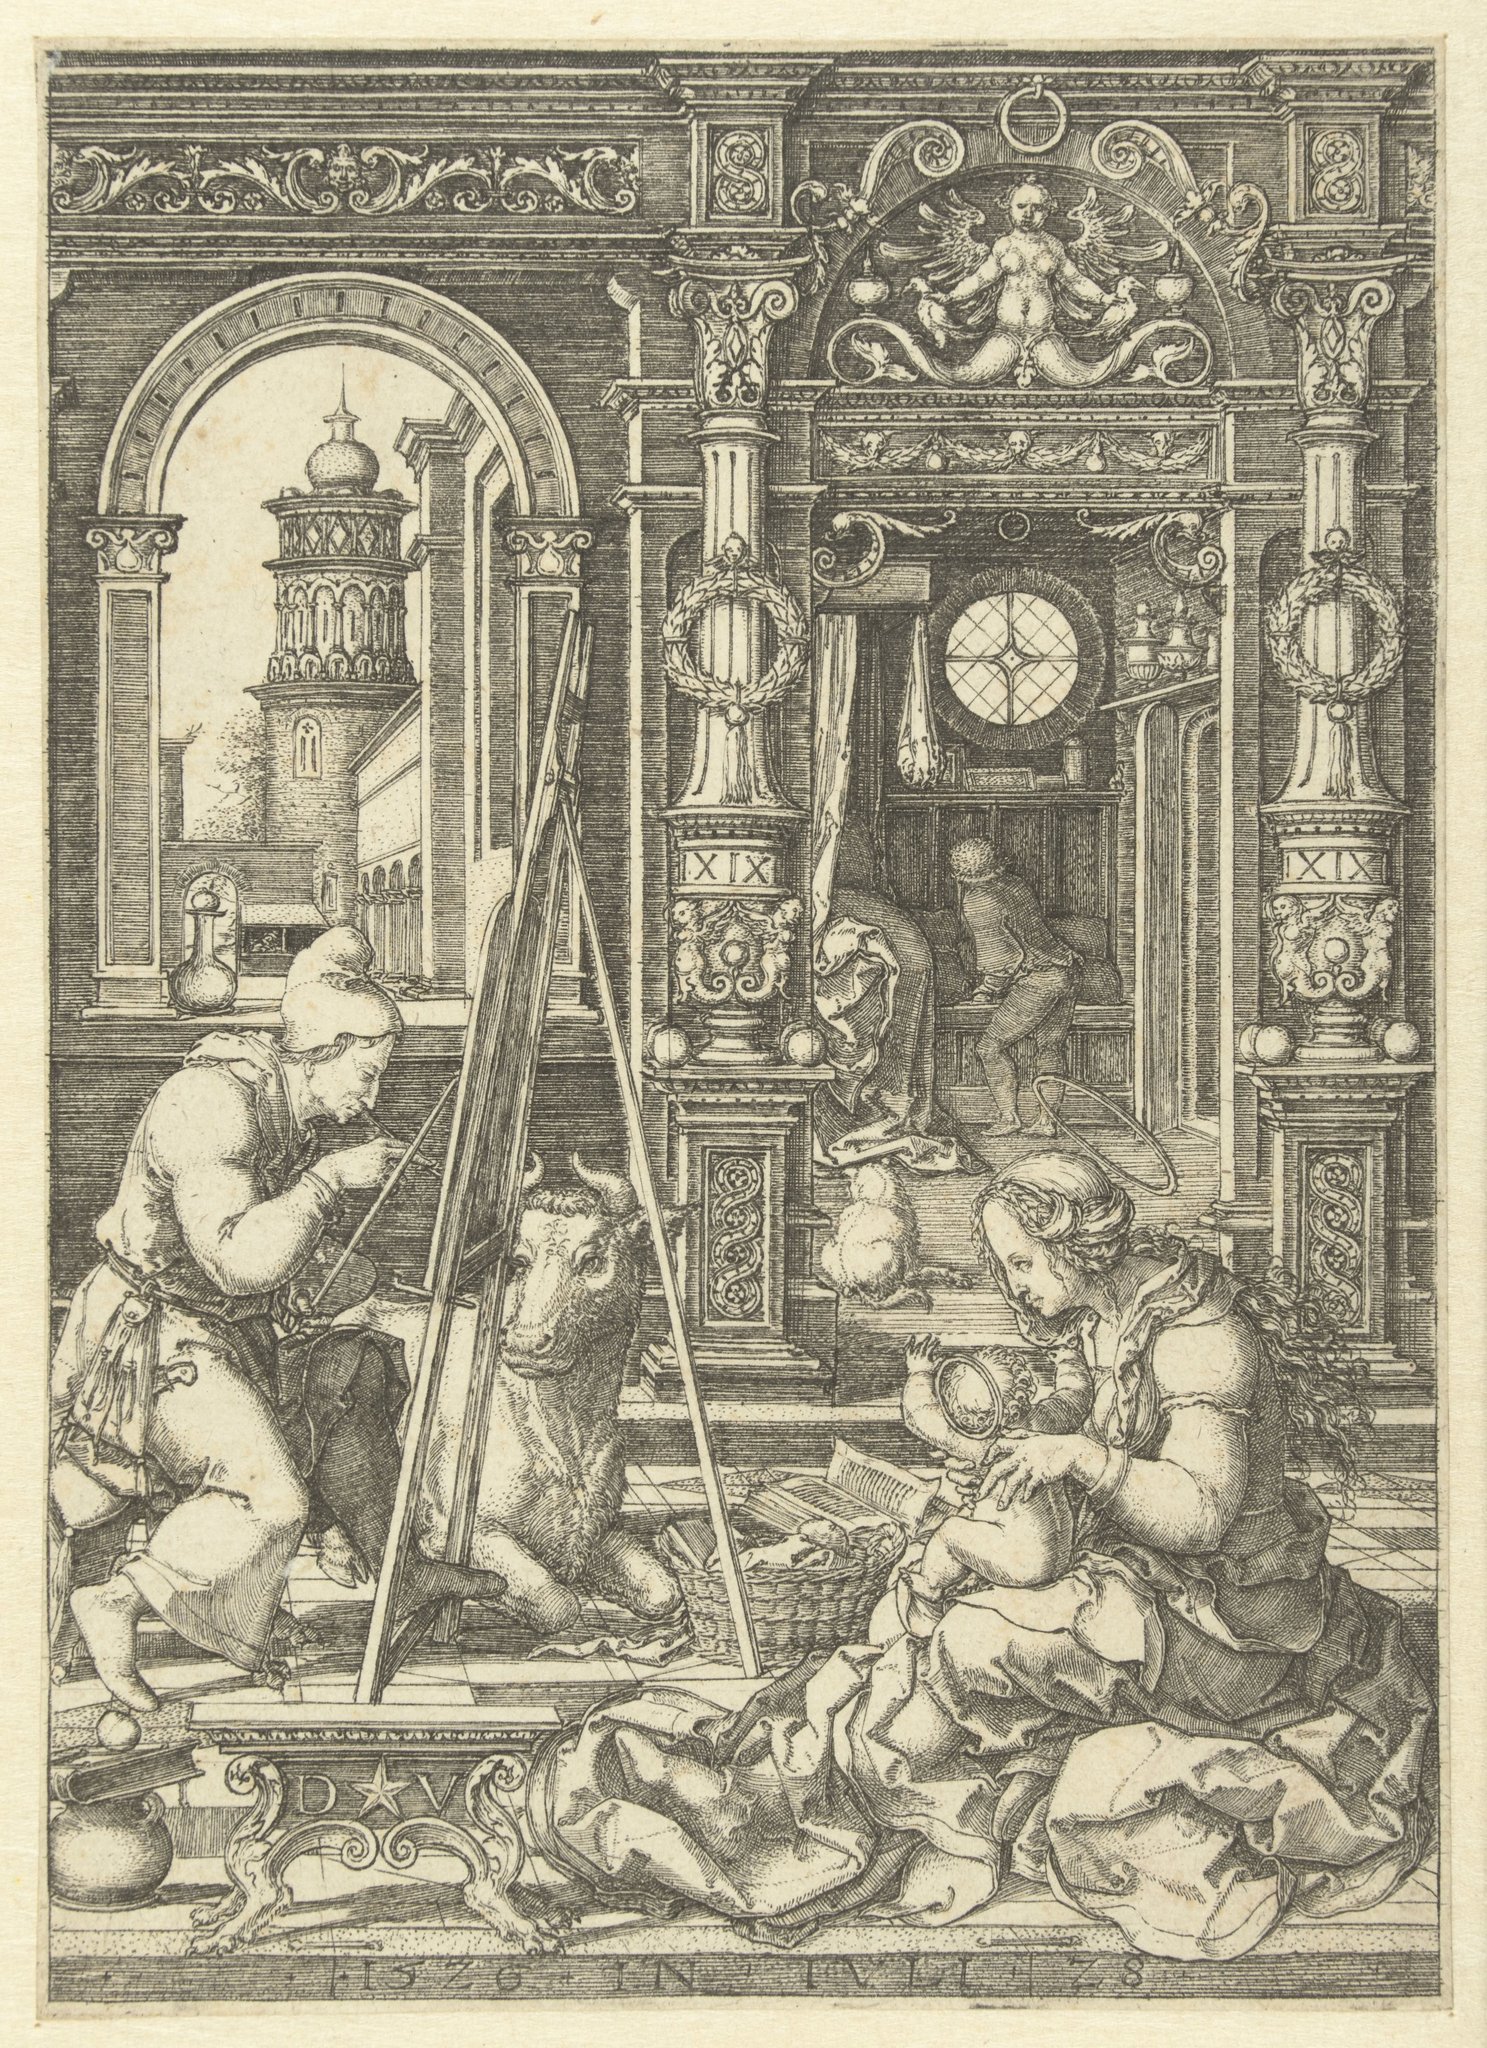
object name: print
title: Heilige Lucas schildert Madonna met kind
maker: dirck vellert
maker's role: draughtsman, painter, print maker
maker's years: 1480-1547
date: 1526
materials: paper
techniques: engraving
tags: st. luke as patron of painters, painter at work with assistants or pupils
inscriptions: collector's mark: Lugt 240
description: Volgens de legende zou de H. Lukas* het portret van Maria hebben geschilderd. In de Nederlanden wordt dit thema sinds de 15de eeuw in de schilderkunst en de grafiek uitgebeeld: Maria zit, met het Kind, model voor de schilderende heilige, die te herkennen is aan het rund, zijn evangelistensymbool. De H. Lukas is hier weergegeven als een eigentijdse meester met palet, penseel en schilderstok. In het aangrenzende vertrek staat een knechtje verf te wrijven.